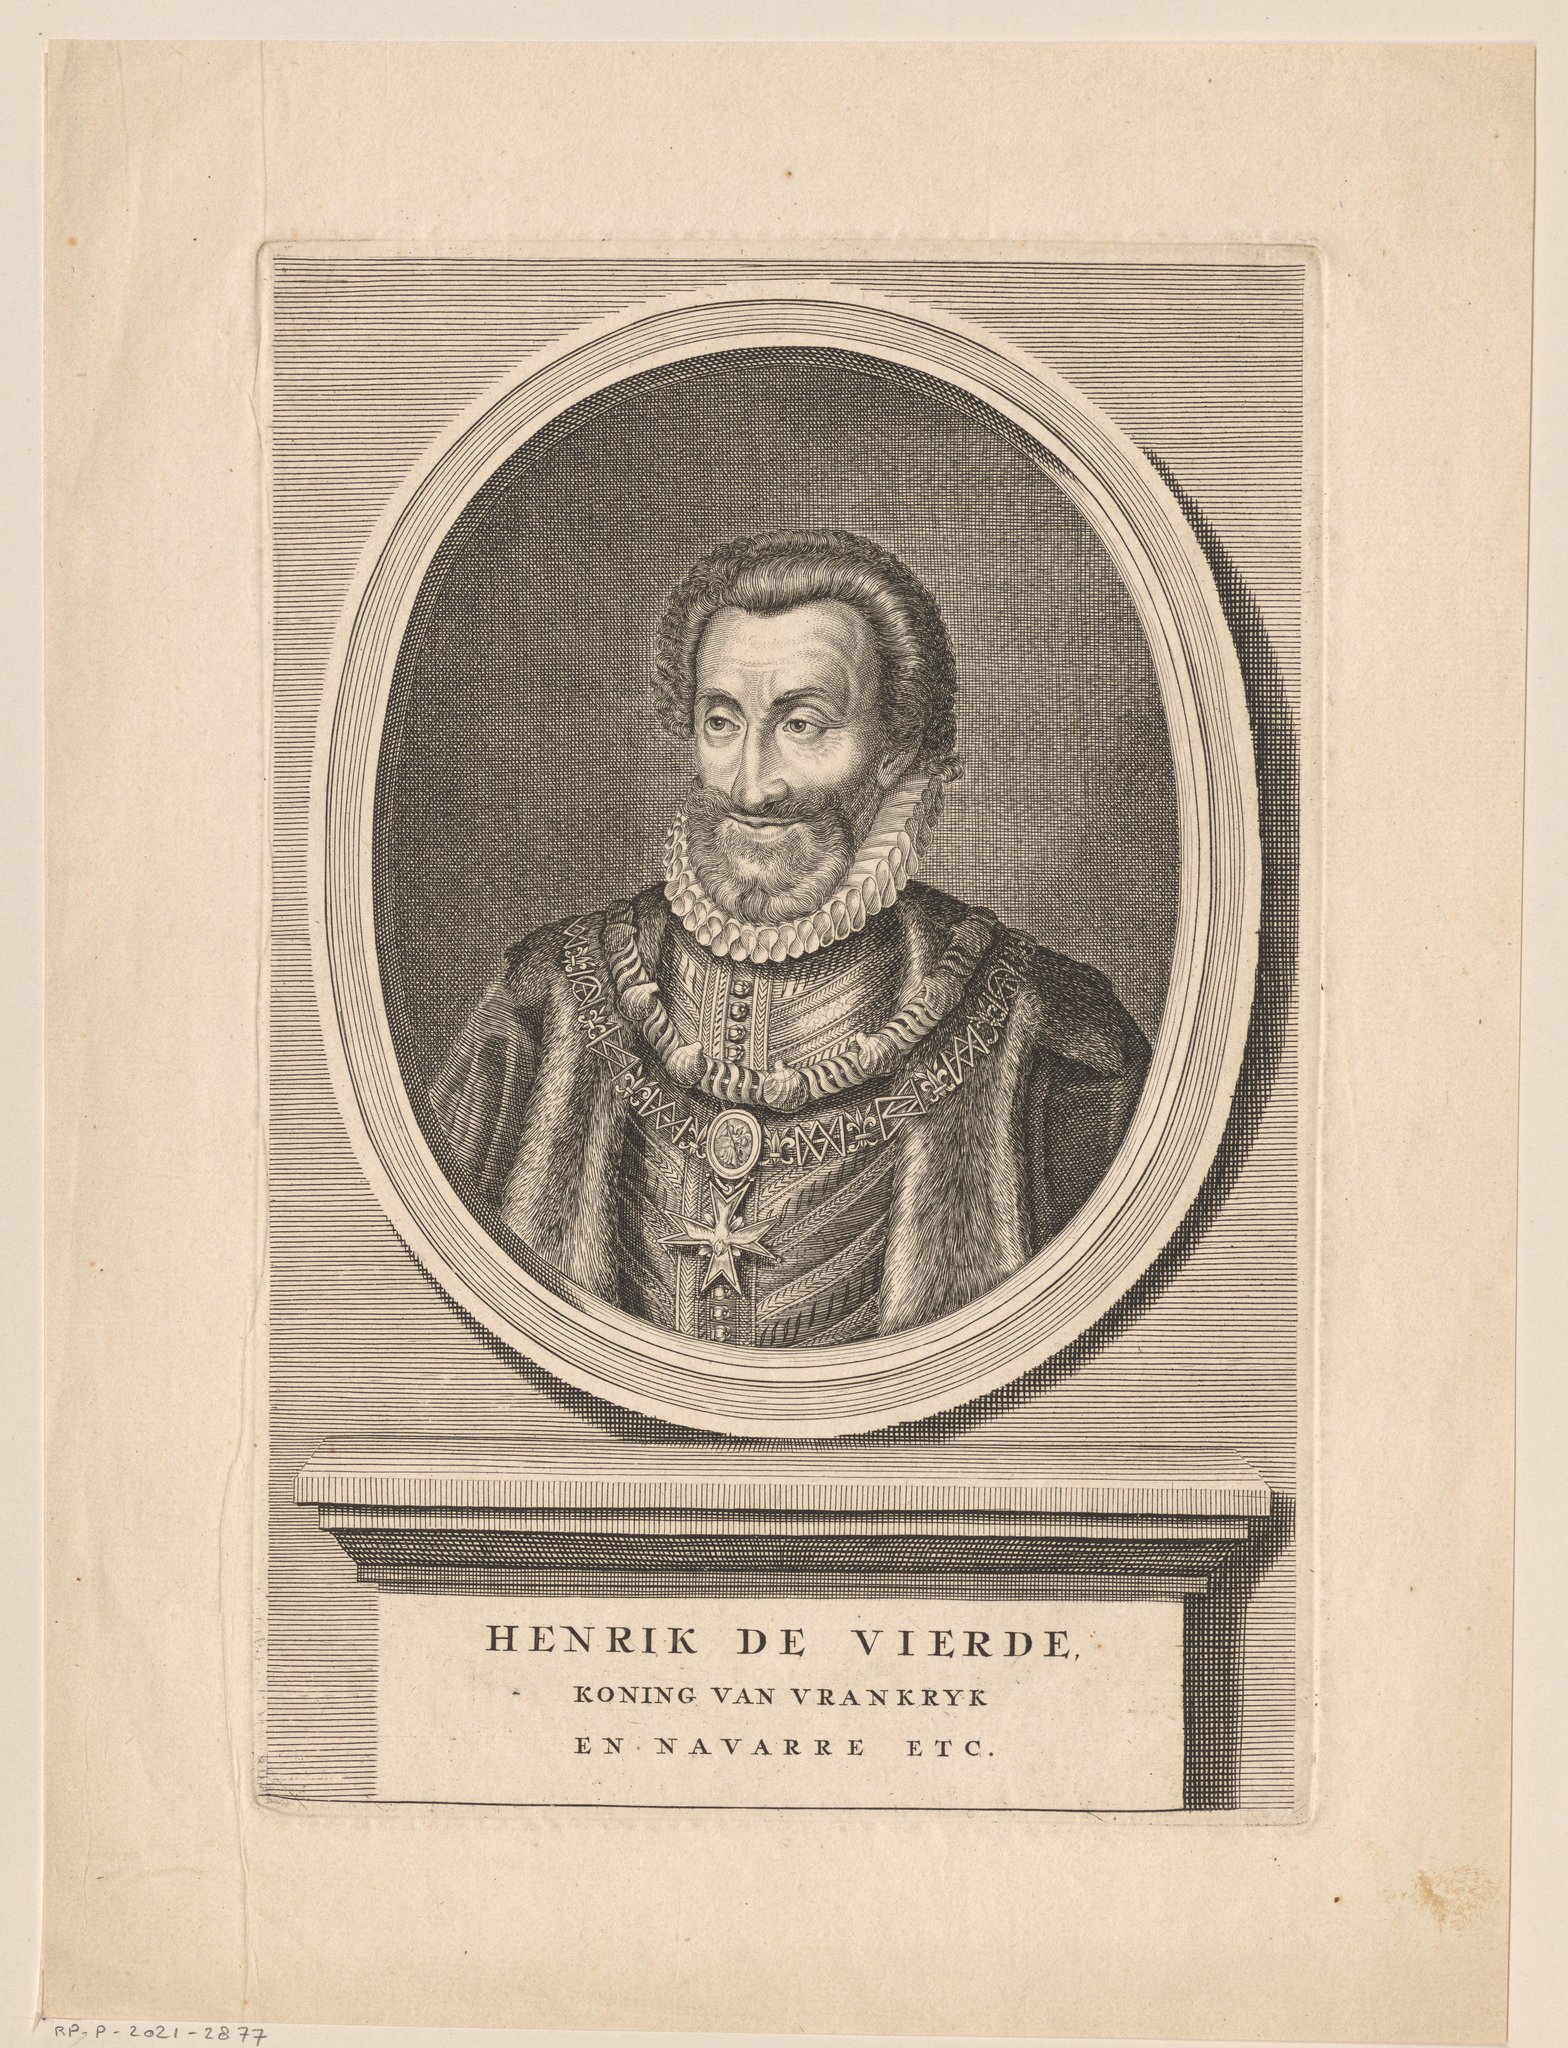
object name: book illustration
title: Portret van Hendrik IV, koning van Frankrijk en Navarra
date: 1684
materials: paper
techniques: engraving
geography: amsterdam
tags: paris, hendrik iv (koning van frankrijk en navarra), historical persons, king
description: Prent uit: Bor, Pieter Christiaensz. Oorsprongk, begin, en vervolgh der Nederlandsche oorlogen, (...). Amsterdam: weduwe Johannes van Someren, Abraham Wolfgang, Hendrick Boom en weduwe Dirk Boom, 1684, dl. 4. Prent met nummering gebruikt in: Clerc, Jean le. Geschiedenissen der Vereenigde Nederlanden: sedert den aanvang van die Republyk (...). Amsterdam: Zacharias Chatelain, 1730, dl. 1. Frederik Muller schrijft het portret toe aan Bernard Picart. Aangezien de prent al in 1684 in een boek is gebruikt, lijkt dat onwaarschijnlijk.